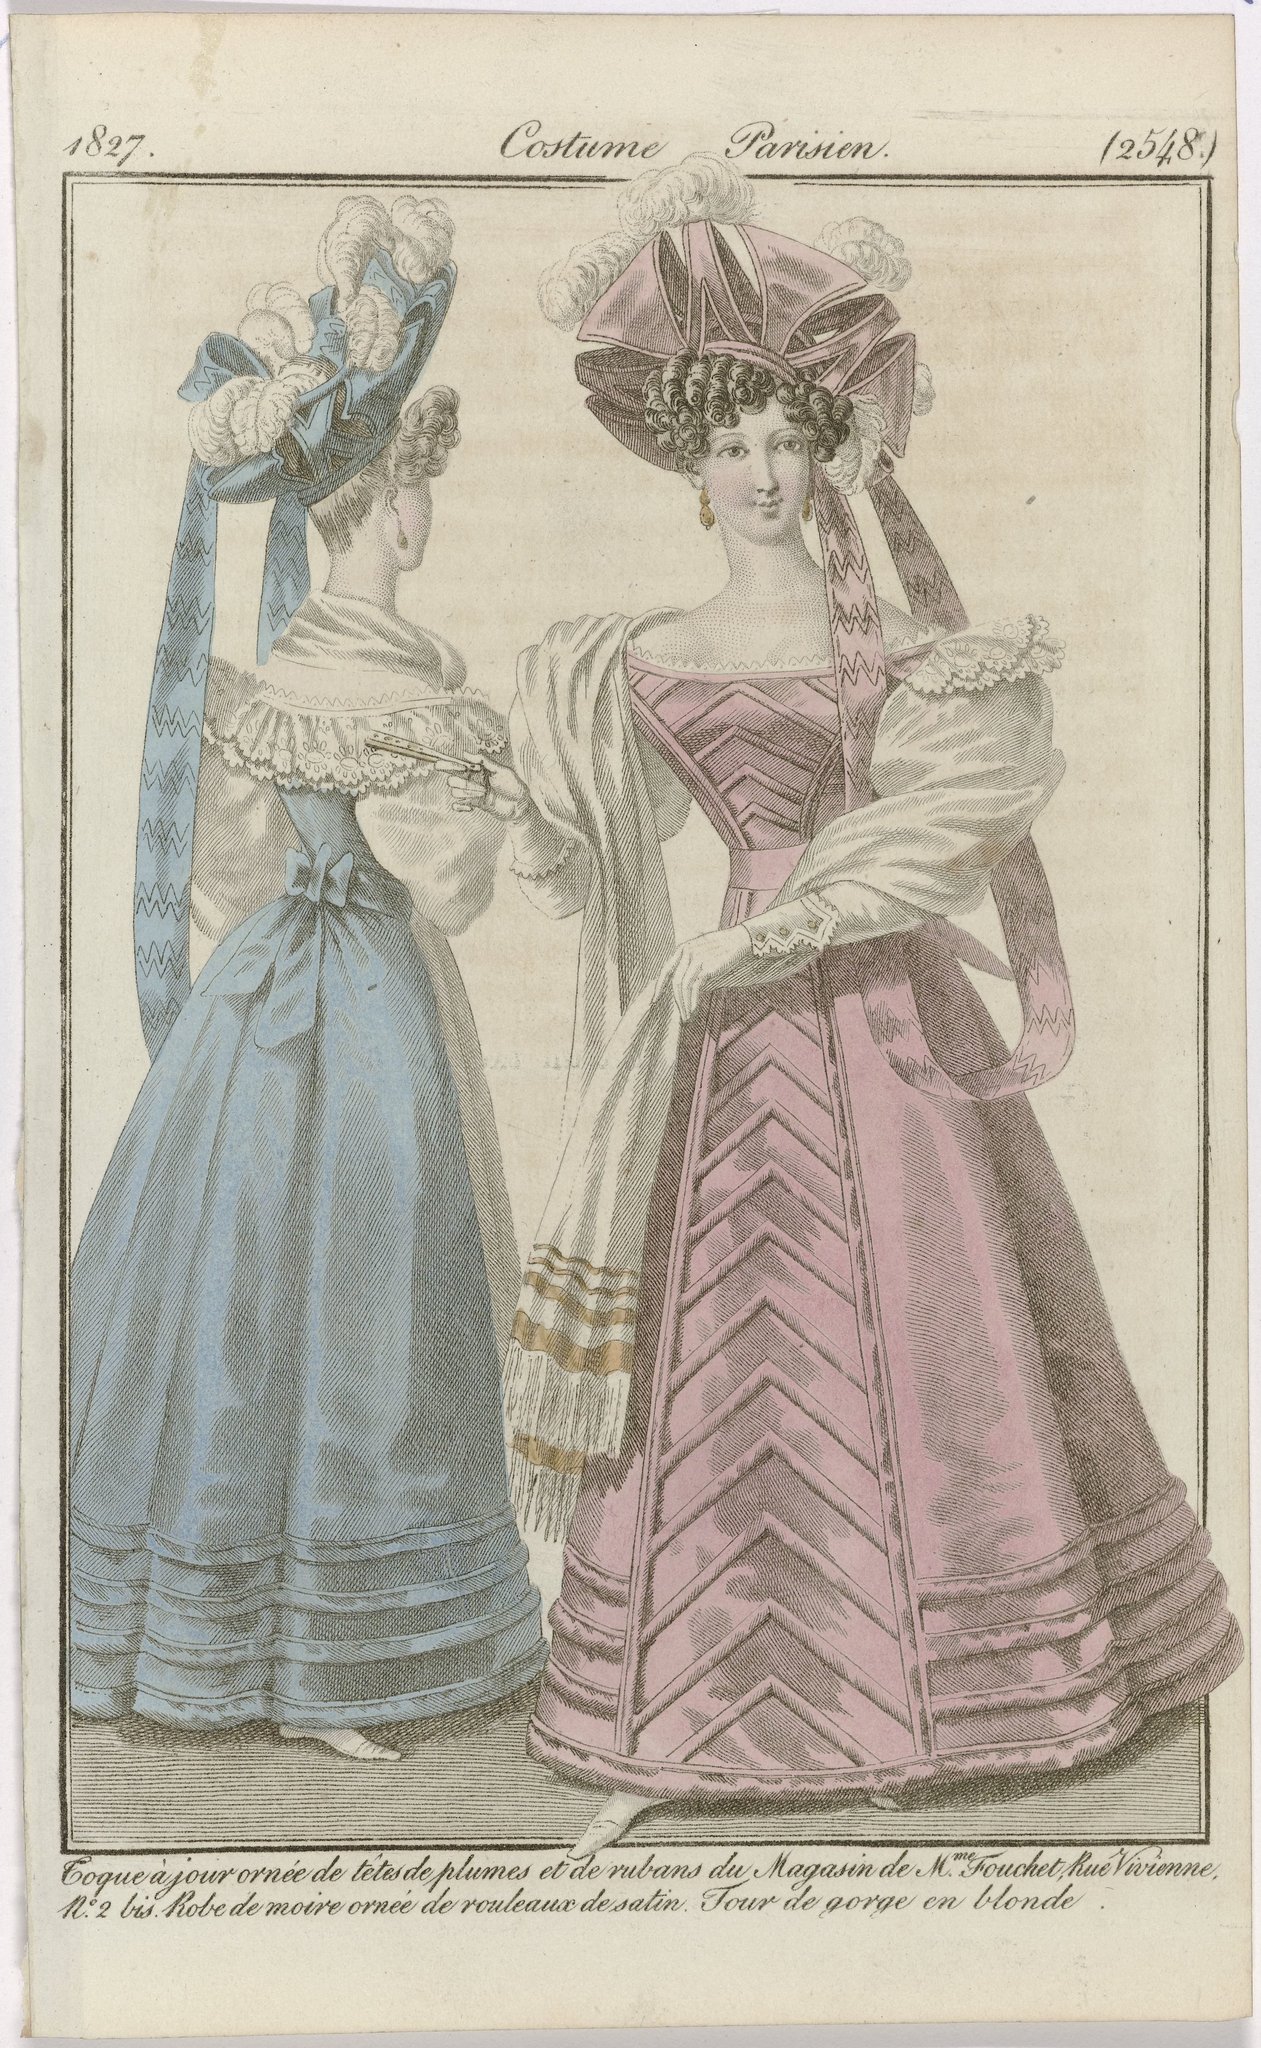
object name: fashion print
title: Journal des Dames et des Modes, Costume Parisien, 5 novembre 1827, (2548): Toque à jour orné (...)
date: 1827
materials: paper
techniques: engraving, hand coloring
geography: paris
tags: ear-rings (+ women's clothes), head-gear: toque (+ women's clothes), clothing for the upper part of the body (shawl) (+ women's clothes), border, ribbon, braid (+ women's clothes), fashion plates, dress, gown (+ women's clothes), fan (+ women's clothes)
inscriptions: caption: ‘Toque à jour ornée de têtes de plumes et de rubans du Magasin de Mme. Fouchet, Rue Vivienne, No.2 bis. Robe de moire ornée de rouleaux de satin. Tour de gorge en blonde.’, title: ‘Costume Parisien.’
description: Vrouw met op het hoofd een opengewerkte 'toque' versierd met veren en linten uit de winkel van Fouchet. Zij draagt een japon van 'moire' versierd met een 'rouleaux' van satijn. 'Tour de gorge' van Blonde (kloskant). Verdere accessoires: oorbellen, sjaal afgezet met franjes, handschoenen, waaier, platte schoen. Figuur in eenzelfde japon, op de rug gezien. De prent maakt deel uit van het modetijdschrift Journal des Dames et des Modes, uitgegeven door Pierre de la Mésangère, Parijs, 1797-1839.